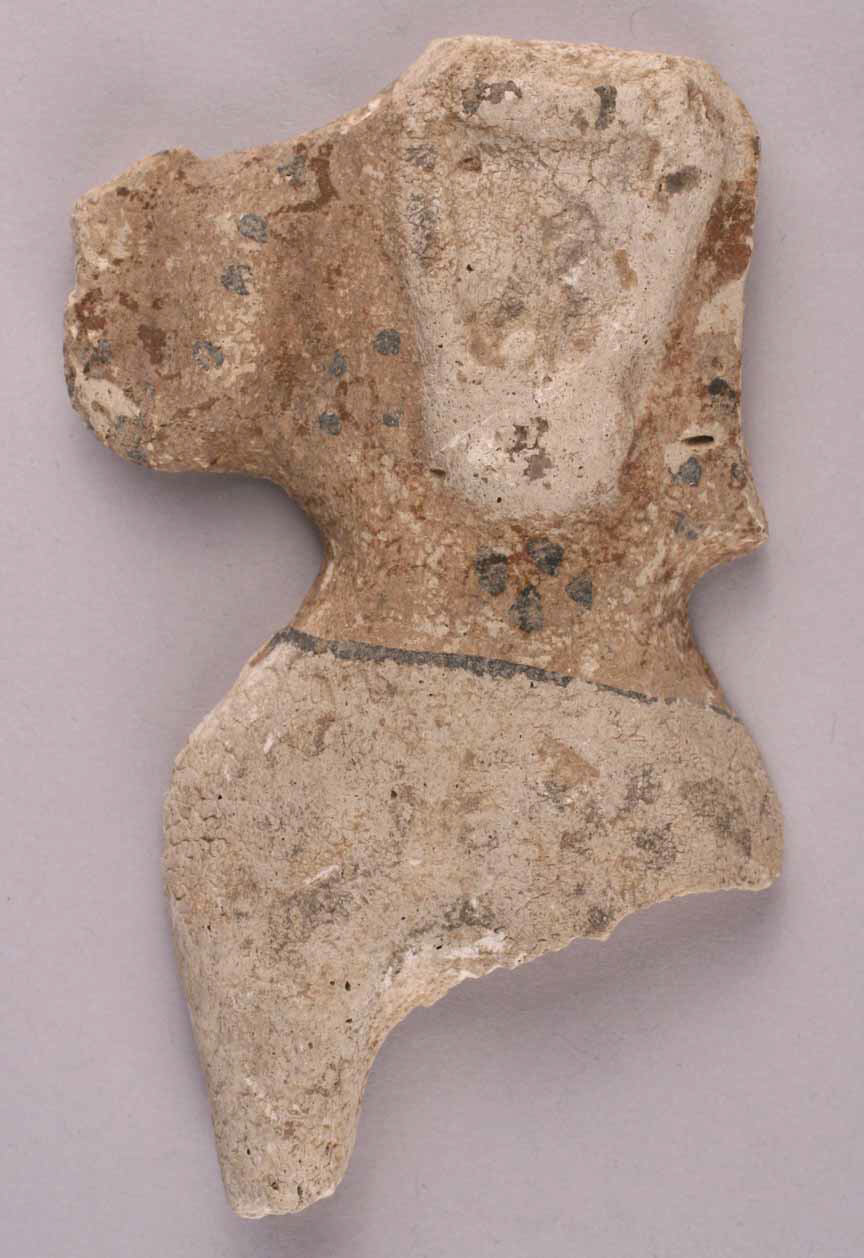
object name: figure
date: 801-900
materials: plaster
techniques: painting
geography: iran